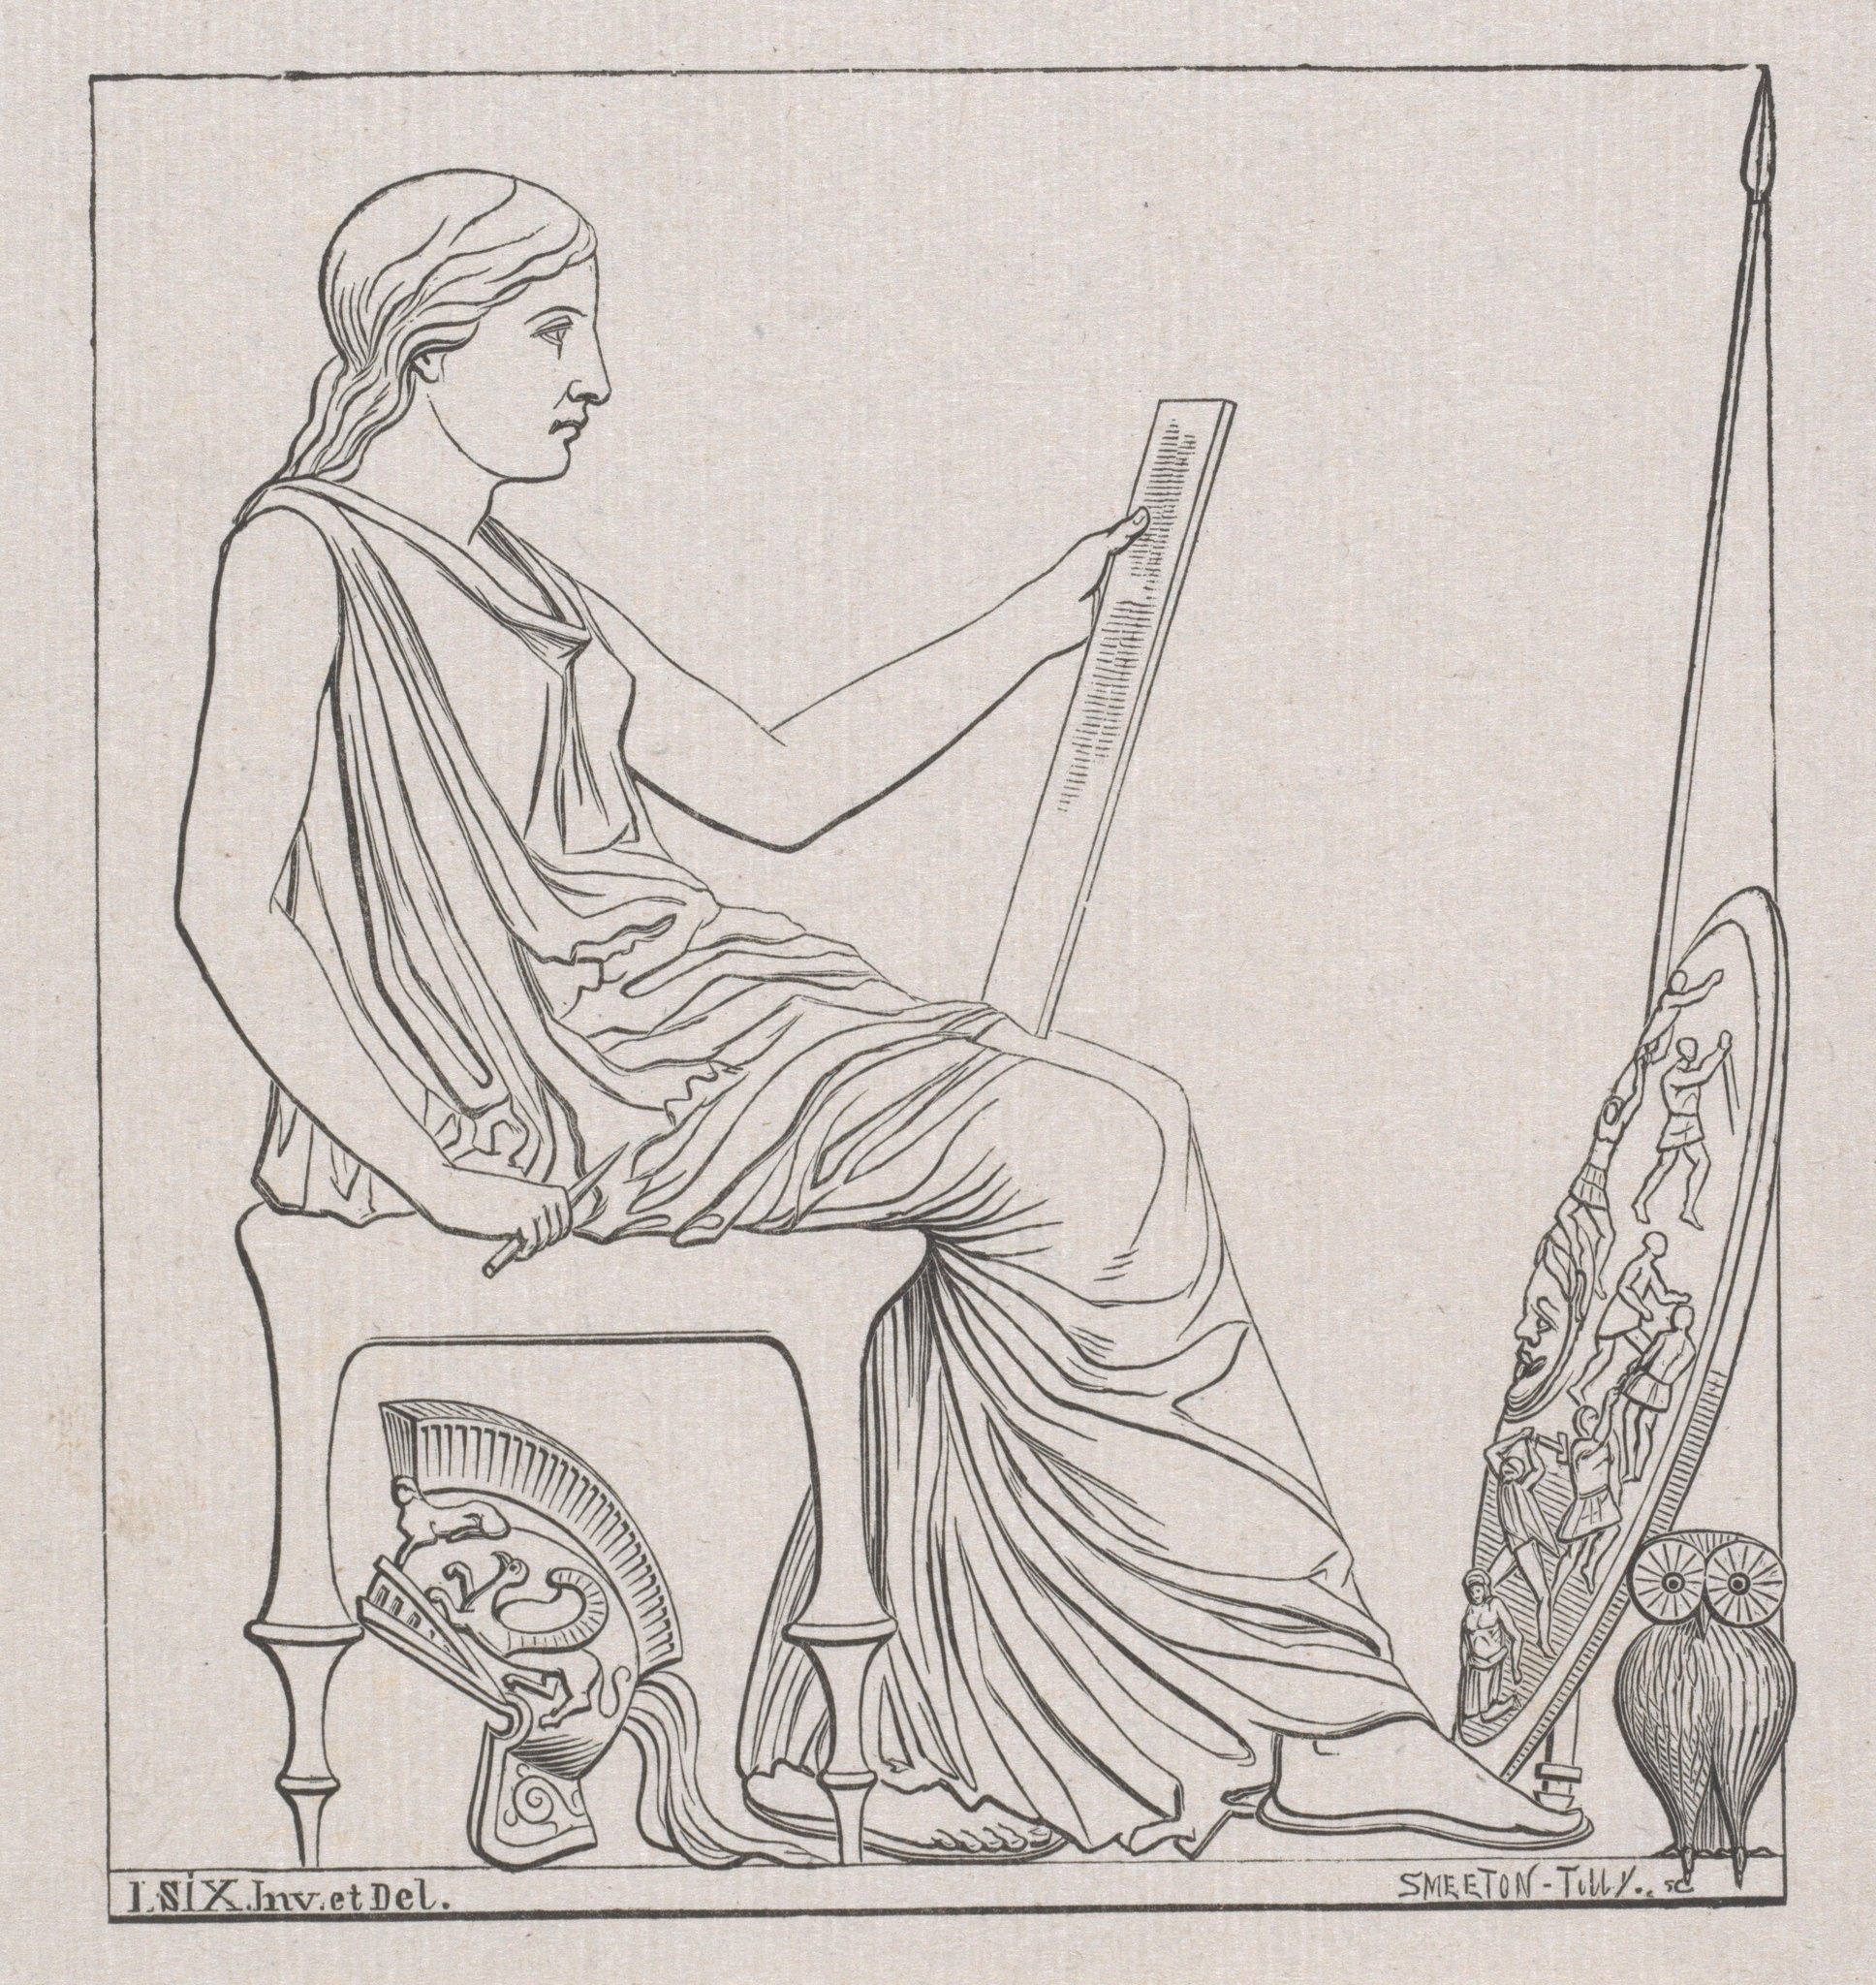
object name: print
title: Vignet met Minerva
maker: i. six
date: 1874-1881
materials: paper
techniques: engraving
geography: paris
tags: (story of) minerva (pallas, athena), attributes of minerva, vignette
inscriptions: collector's mark: Lugt 2228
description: Minerva zittend met in haar rechterhand een stift. Aan haar voeten ligt haar helm, staat haar schild, haar lans en een uil.